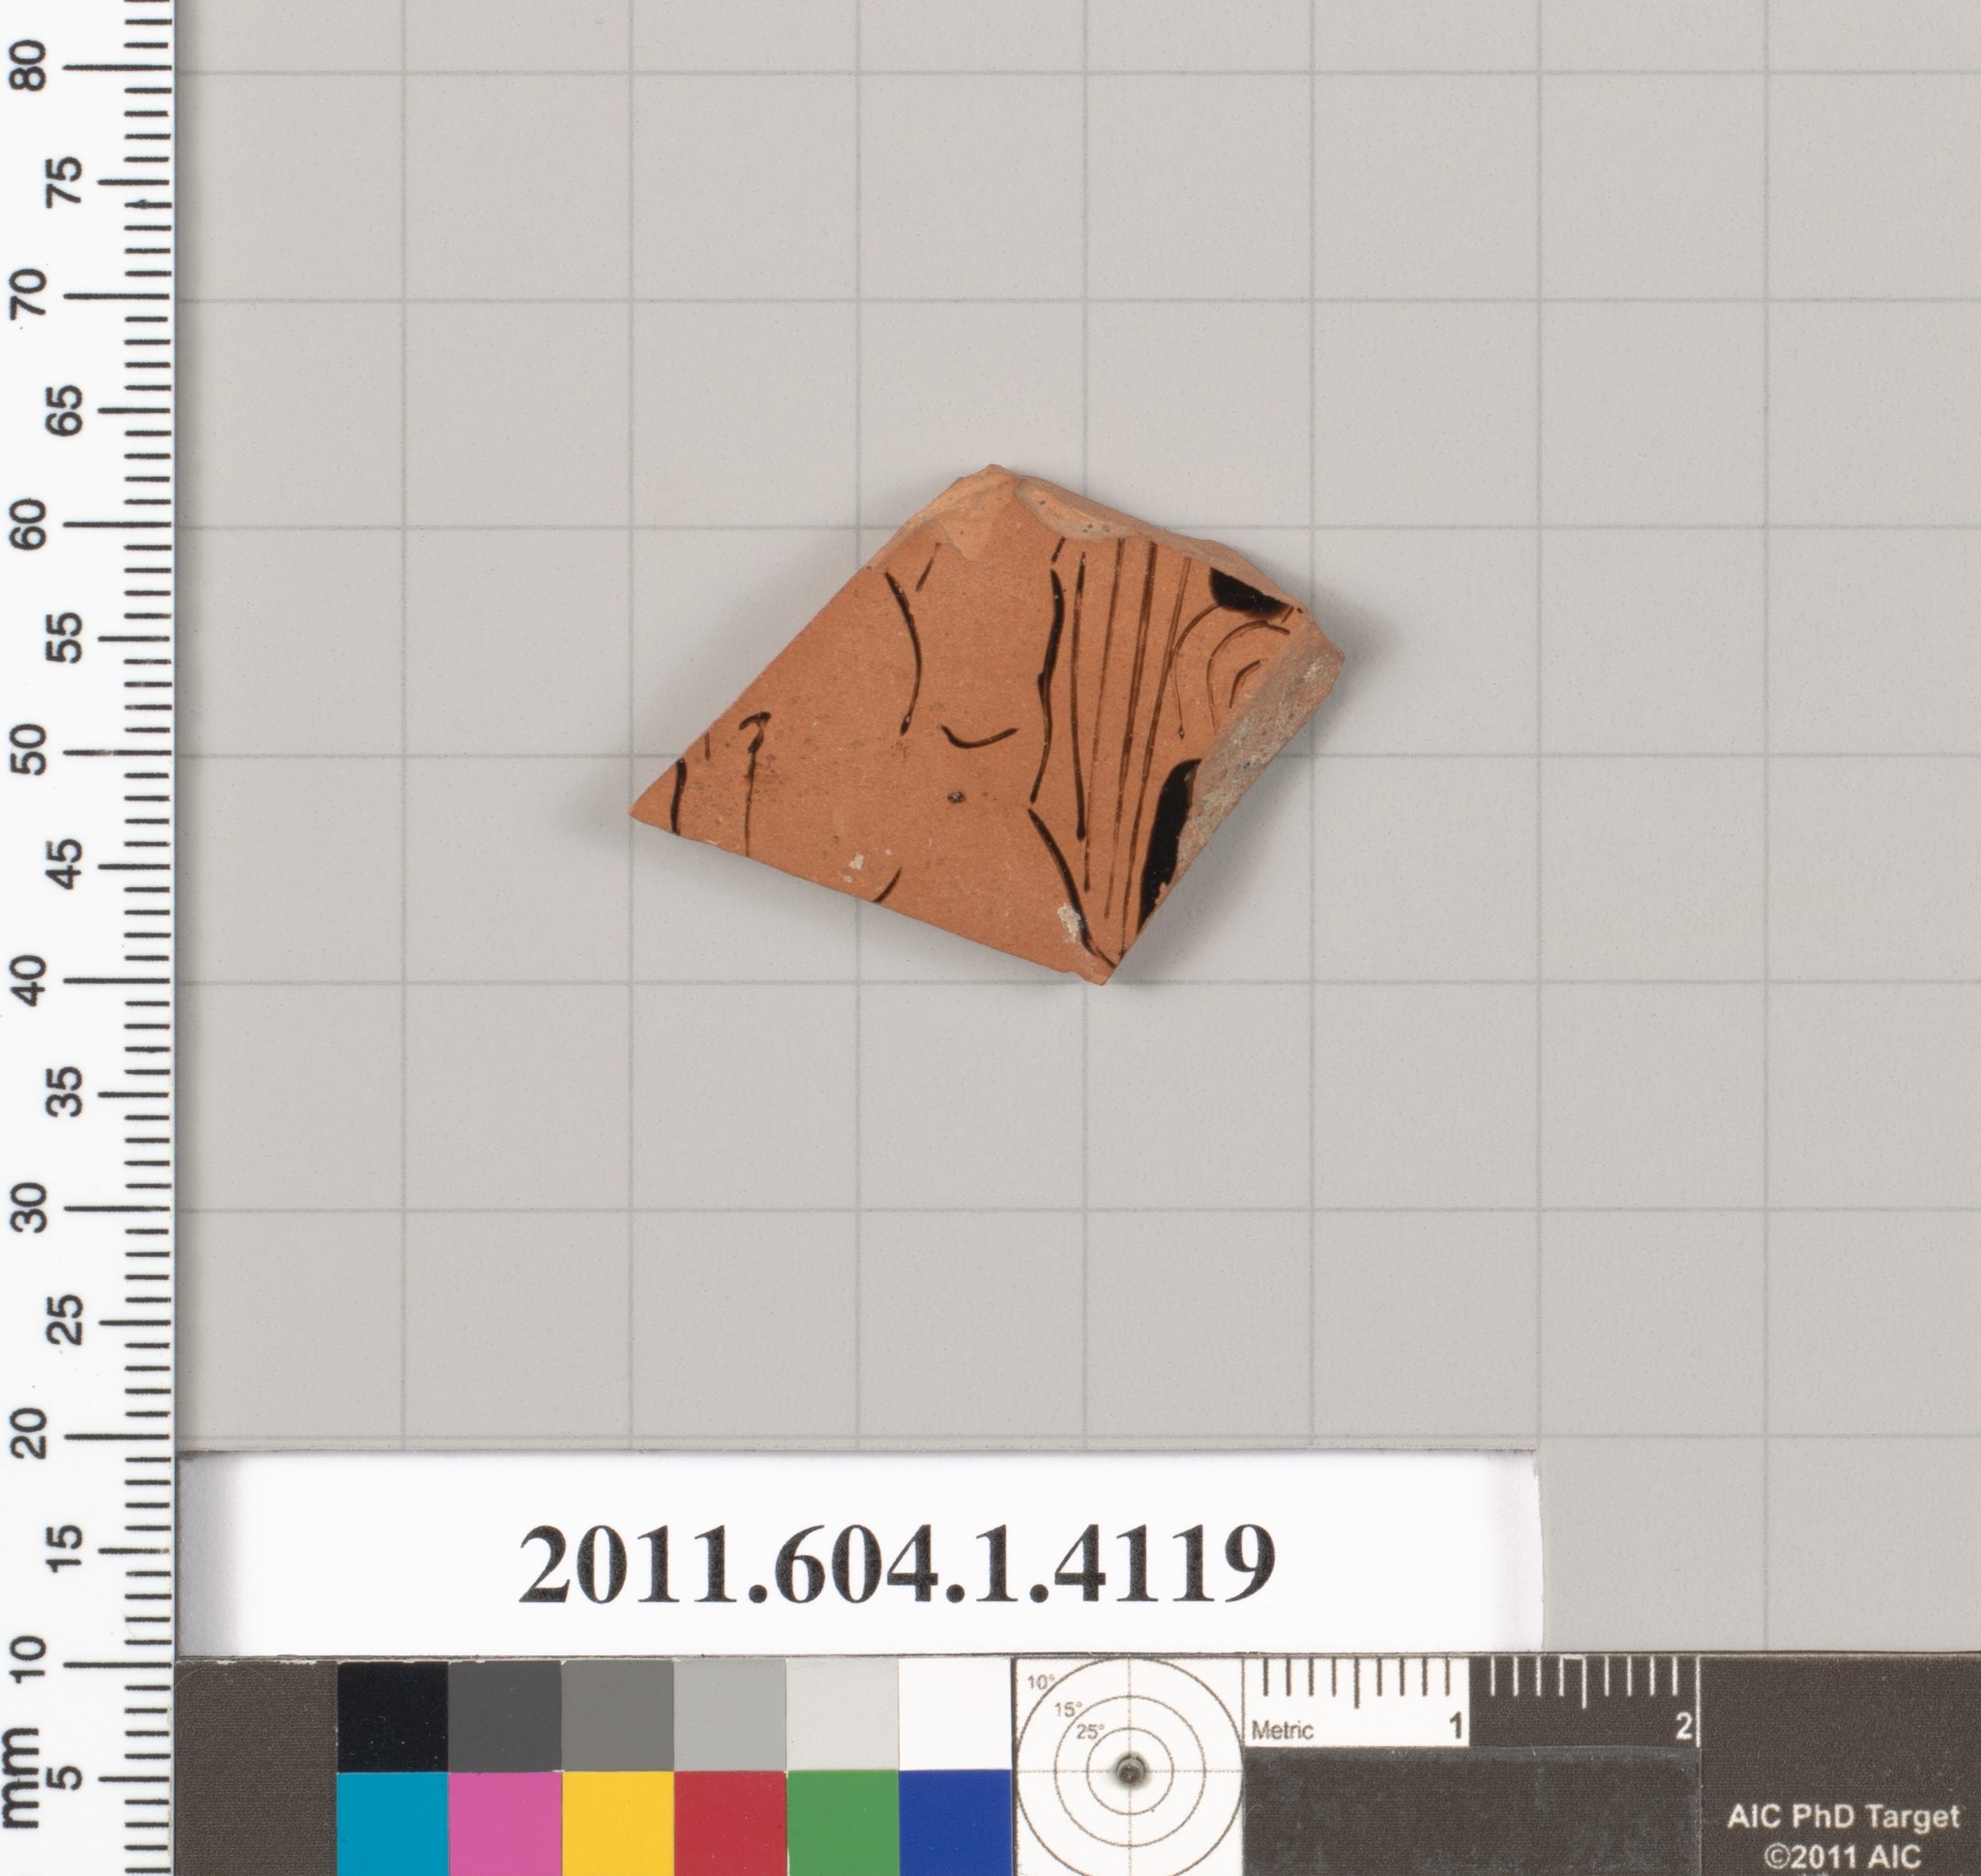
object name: kylix fragment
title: Terracotta fragment of a kylix (drinking cup)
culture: greek, attic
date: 475-451 BCE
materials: terracotta